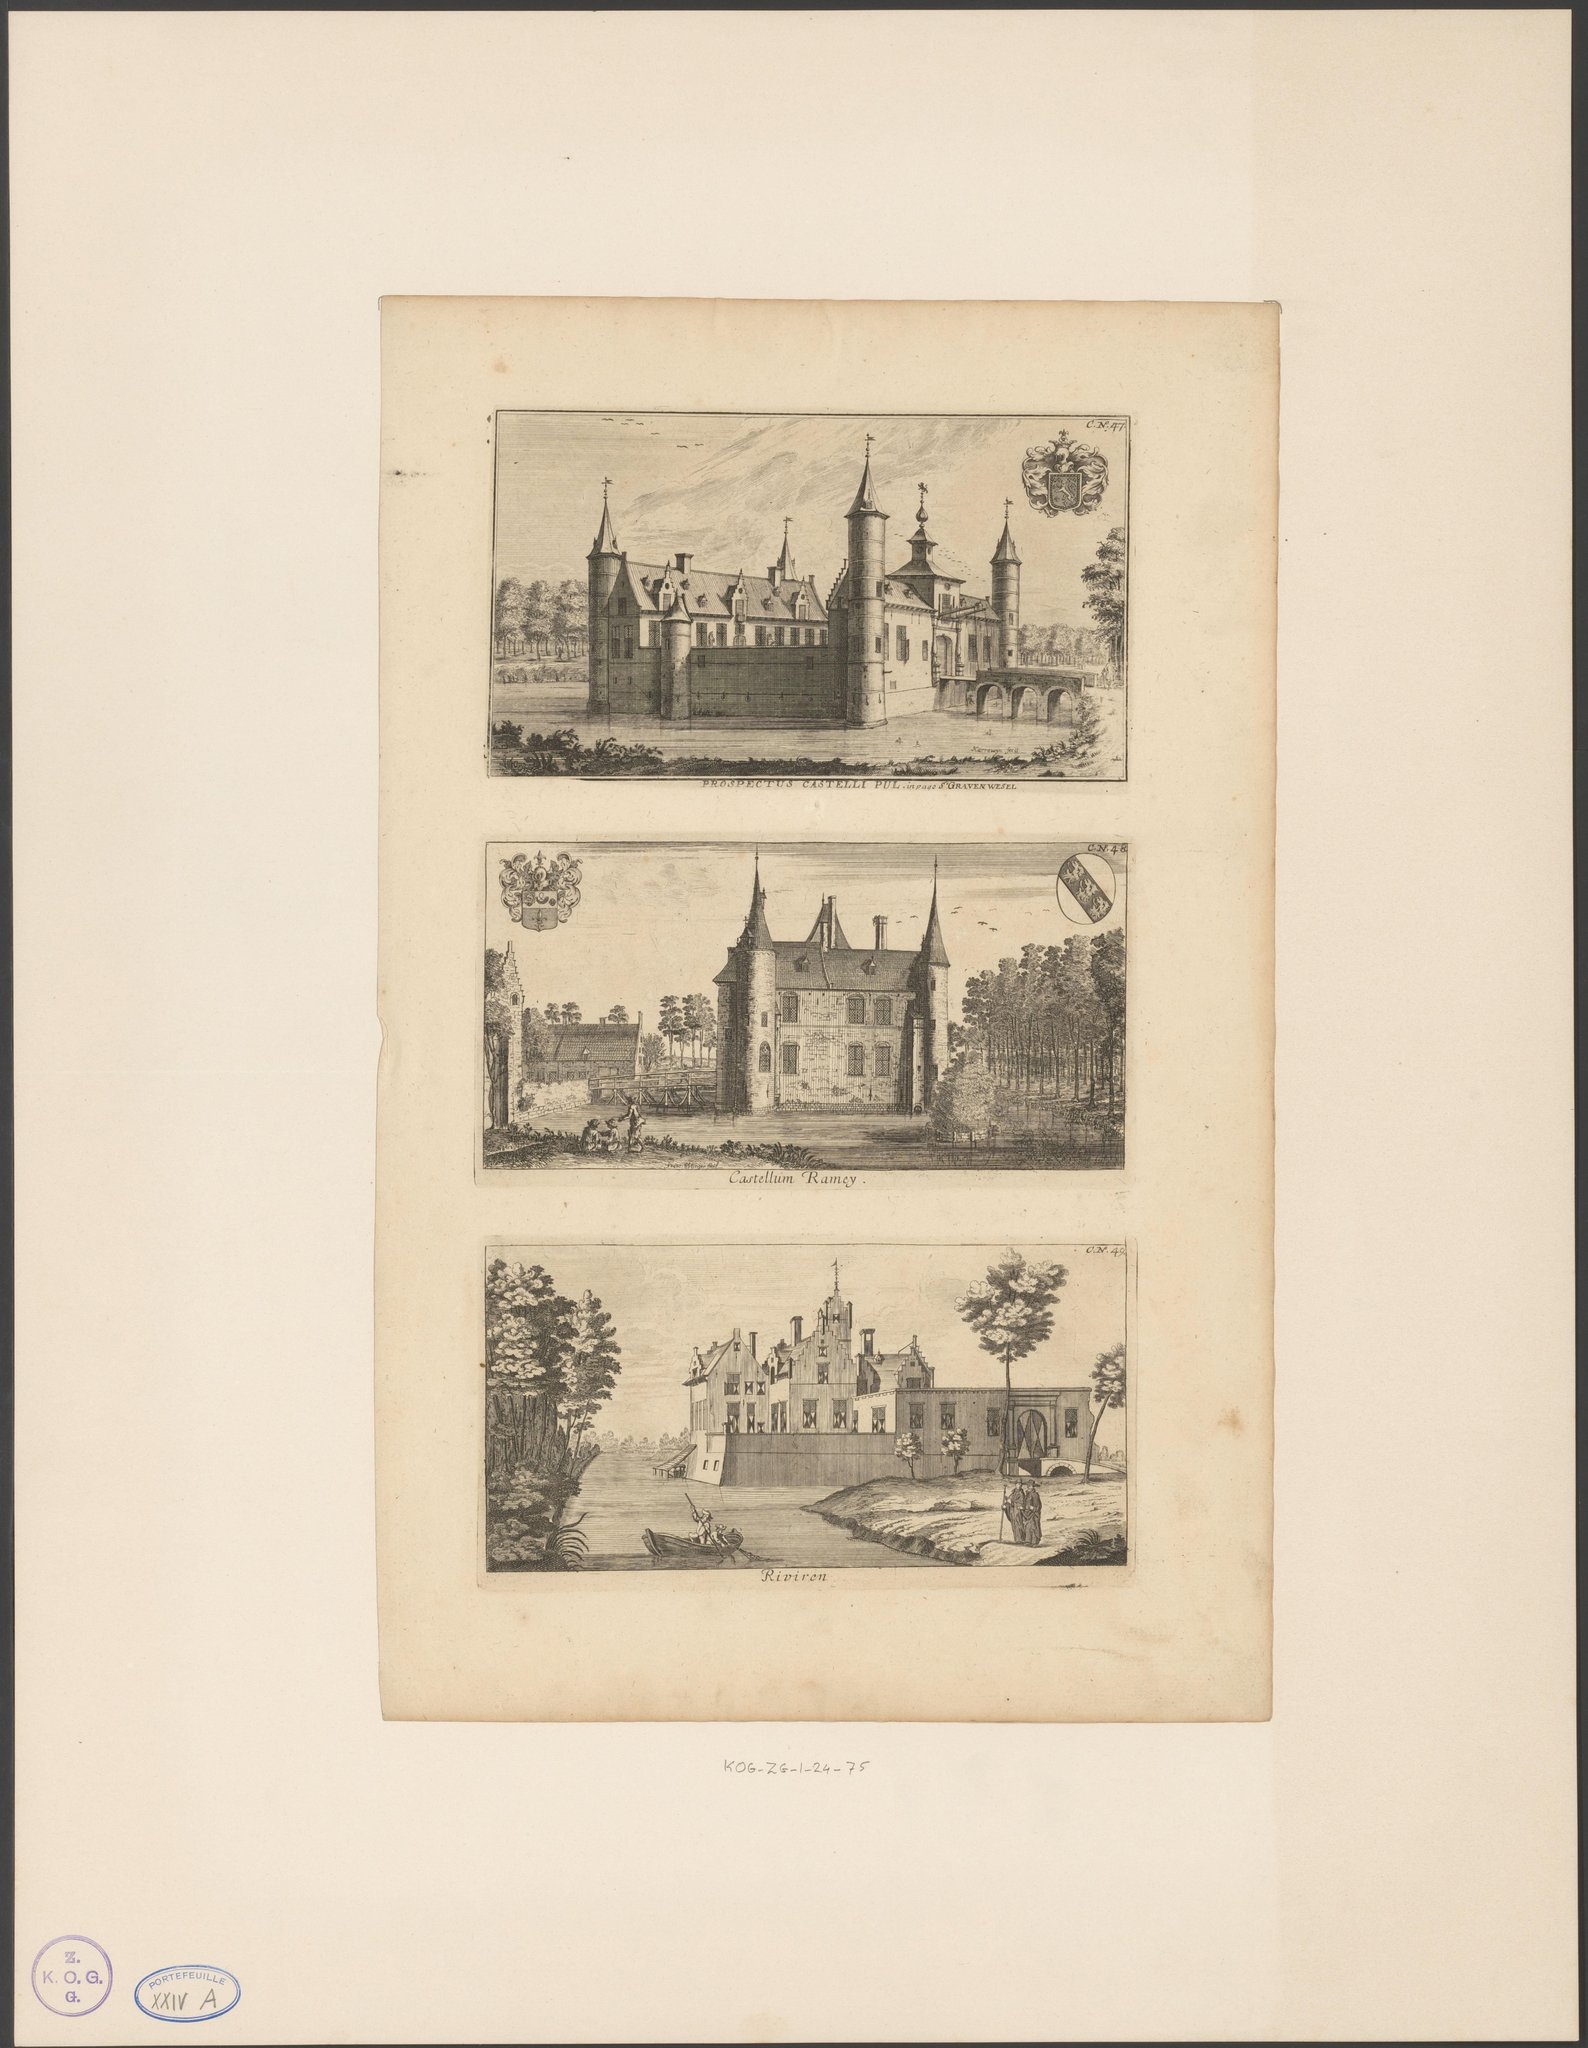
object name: print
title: Kastelen in Brabant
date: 1700-1799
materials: paper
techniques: engraving, etching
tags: castle, rural housing, e.g. country-house, villa, cottage, landscape with tower or castle, armorial bearing, heraldry, antwerp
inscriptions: collector's mark: Lugt 1641, stamp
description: Bovenste plaat heeft rechtsboven een wapenschild. Middelste plaat bovenaan twee wapenschilden. Iedere prent is rechtsboven genummerd: C.No. 47, C.No. 48, C.No. 49. Onderwerpsrubrieken binnen de Atlas Zeden en Gewoonten: Zeden en Gewoonten in Engeren Zin, De Woning. Kastelen en buitenplaatsen. Over de Grenzen.